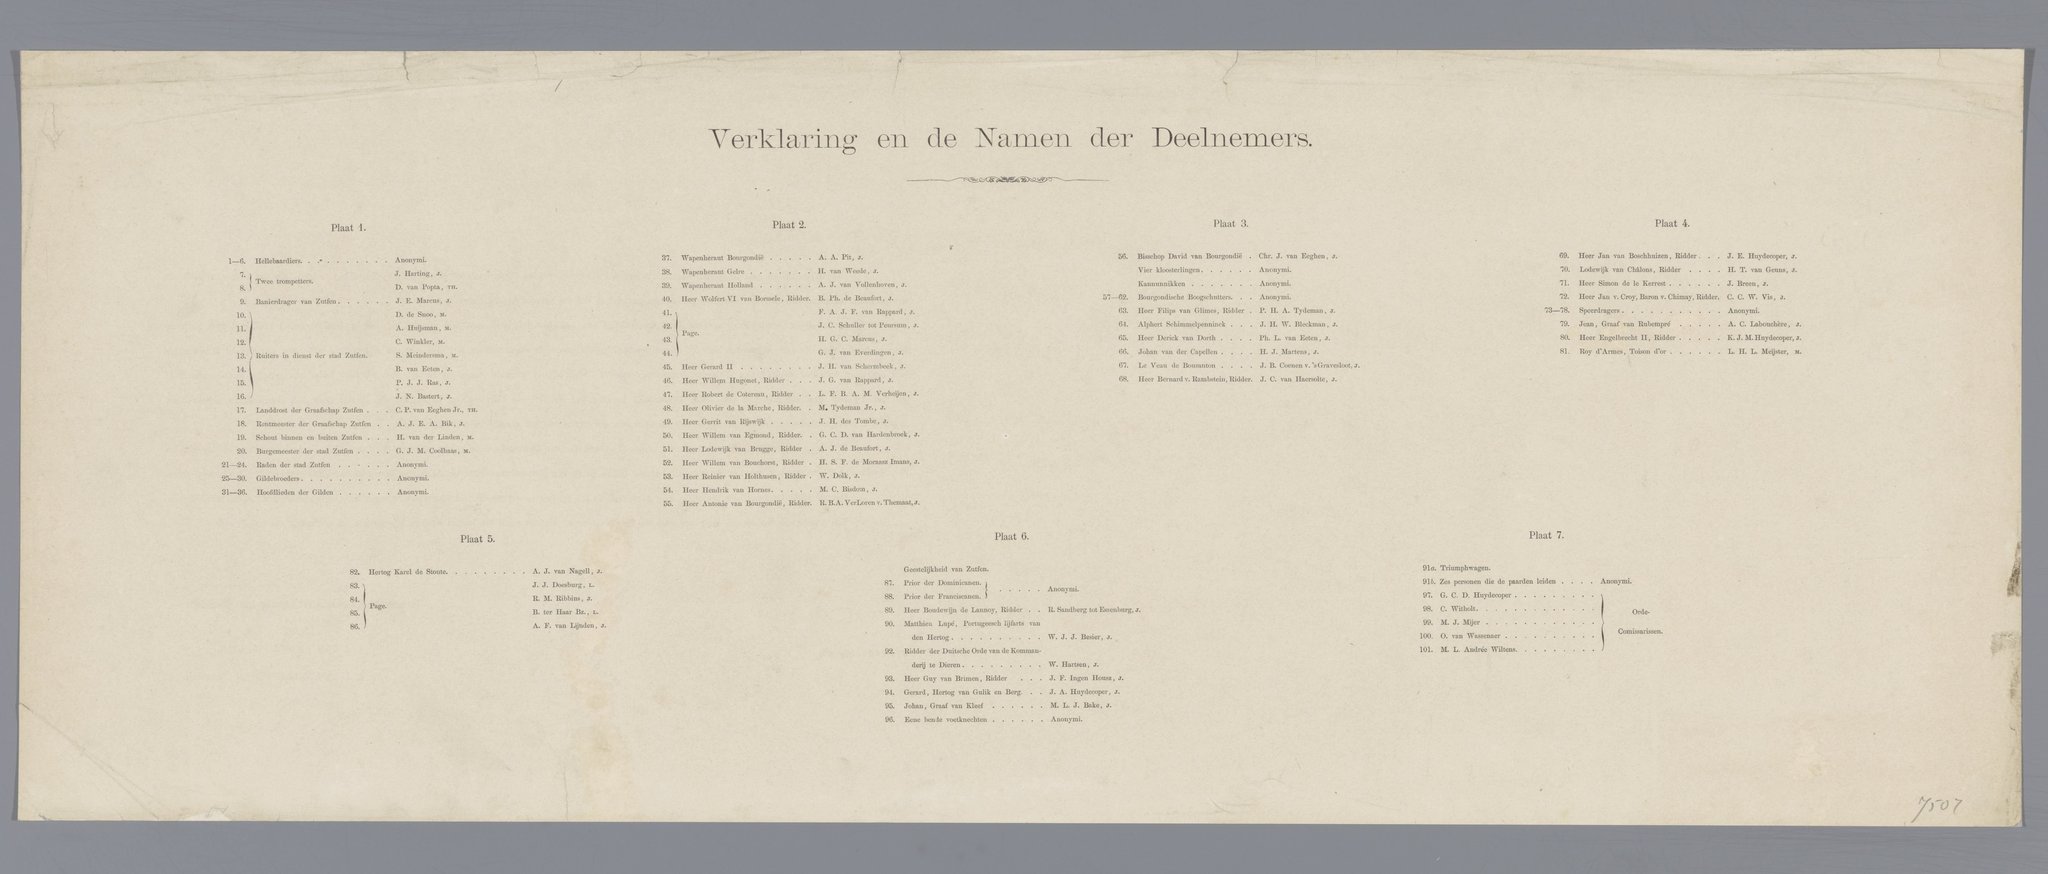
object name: print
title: Utrechtse maskerade van 1876 (verklaring)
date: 1806-1876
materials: paper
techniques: letterpress printing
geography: netherlands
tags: earl, charles the bold (duke of burgundy), students' pageant, costumes used in pageants, commemoration of the founding of a university, utrecht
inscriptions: collector's mark: Lugt 2228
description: Tekstblad met een verklaring met de namen van de voorgestelde historische personages en de namen van de deelnemende studenten in de zeven platen. Op de achterzijde een inleiding names de uitvoerende commissie. Onderdeel van een serie van zeven platen plus titelprent en verklaring van de gecostumeerde optocht georganiseerd door de studenten van de Utrechtse Hogeschool ter viering van de 48e lustrum op 27 juni 1876. De optocht stelt voor de intocht van Karel te Stoute te Zutphen op 4 augustus 1473.